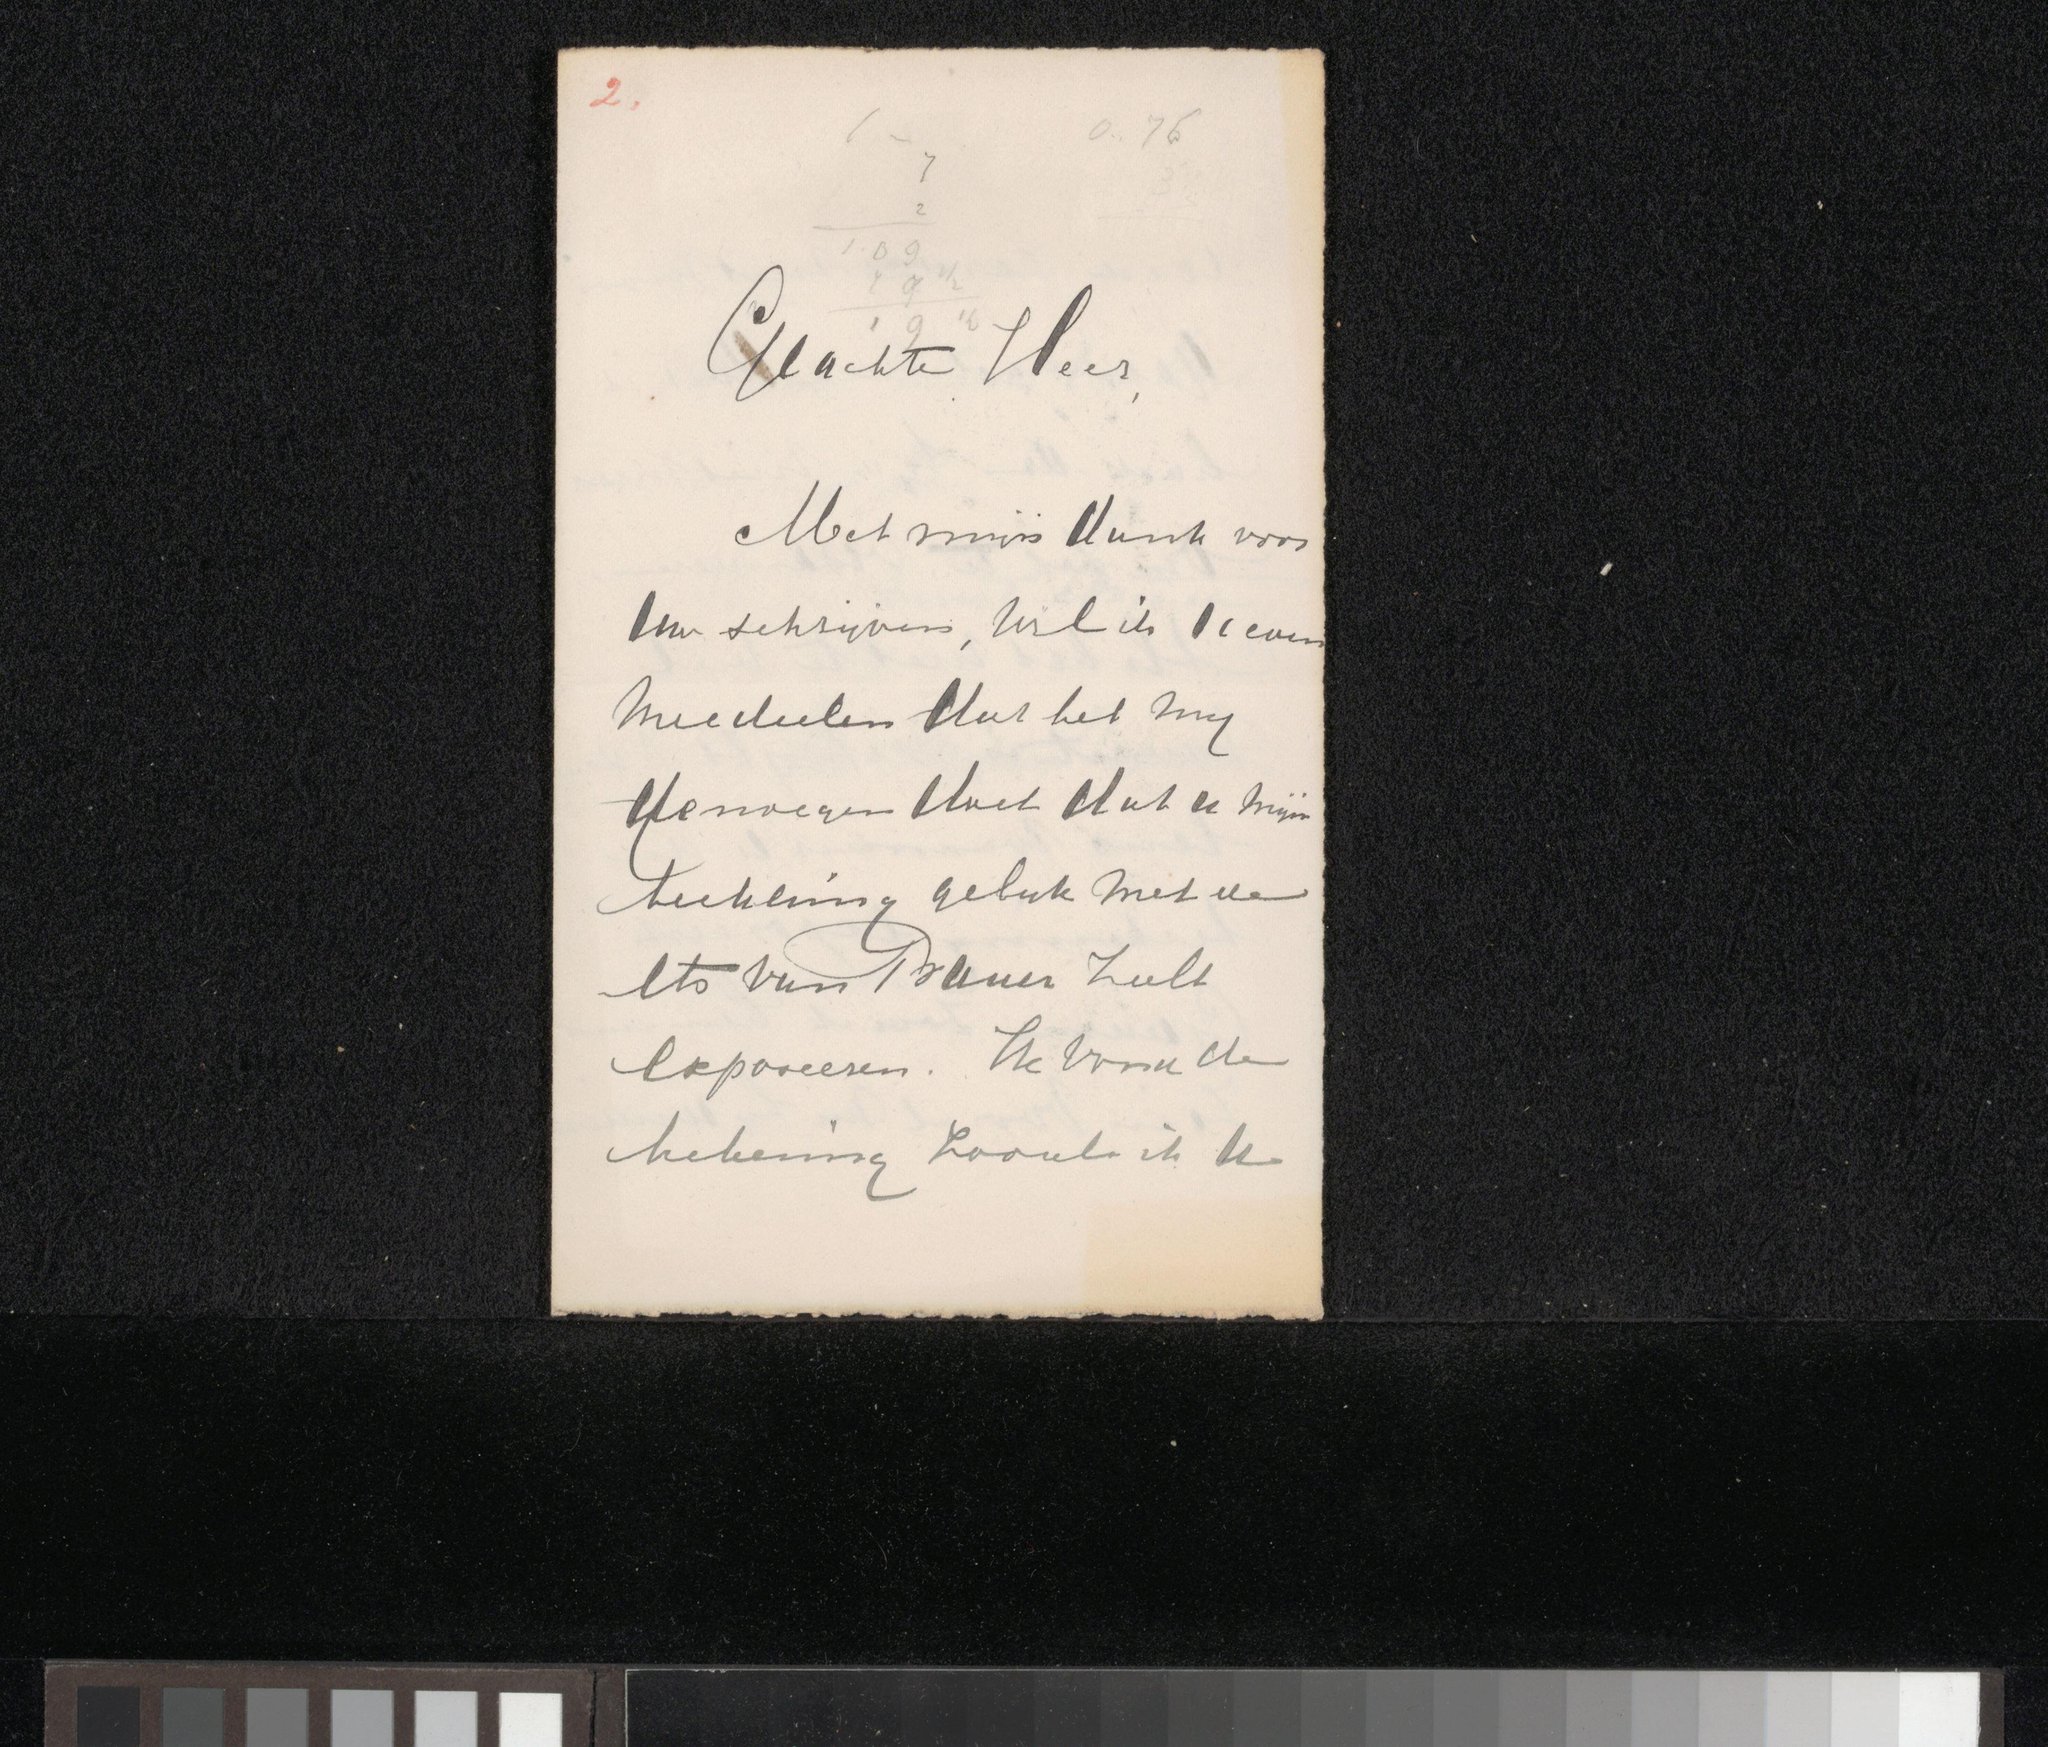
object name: letter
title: Brief aan Pieter Haverkorn van Rijsewijk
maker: suze robertson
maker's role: draughtsman, painter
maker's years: 1855-1922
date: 1901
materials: ink, paper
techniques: pen, writing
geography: the hague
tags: the hague, amsterdam, print maker, draughtsman, marius bauer, pieter haverkorn van rijsewijk, drawing, the graphic arts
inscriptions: collector's mark: ‘RPK’, watermark